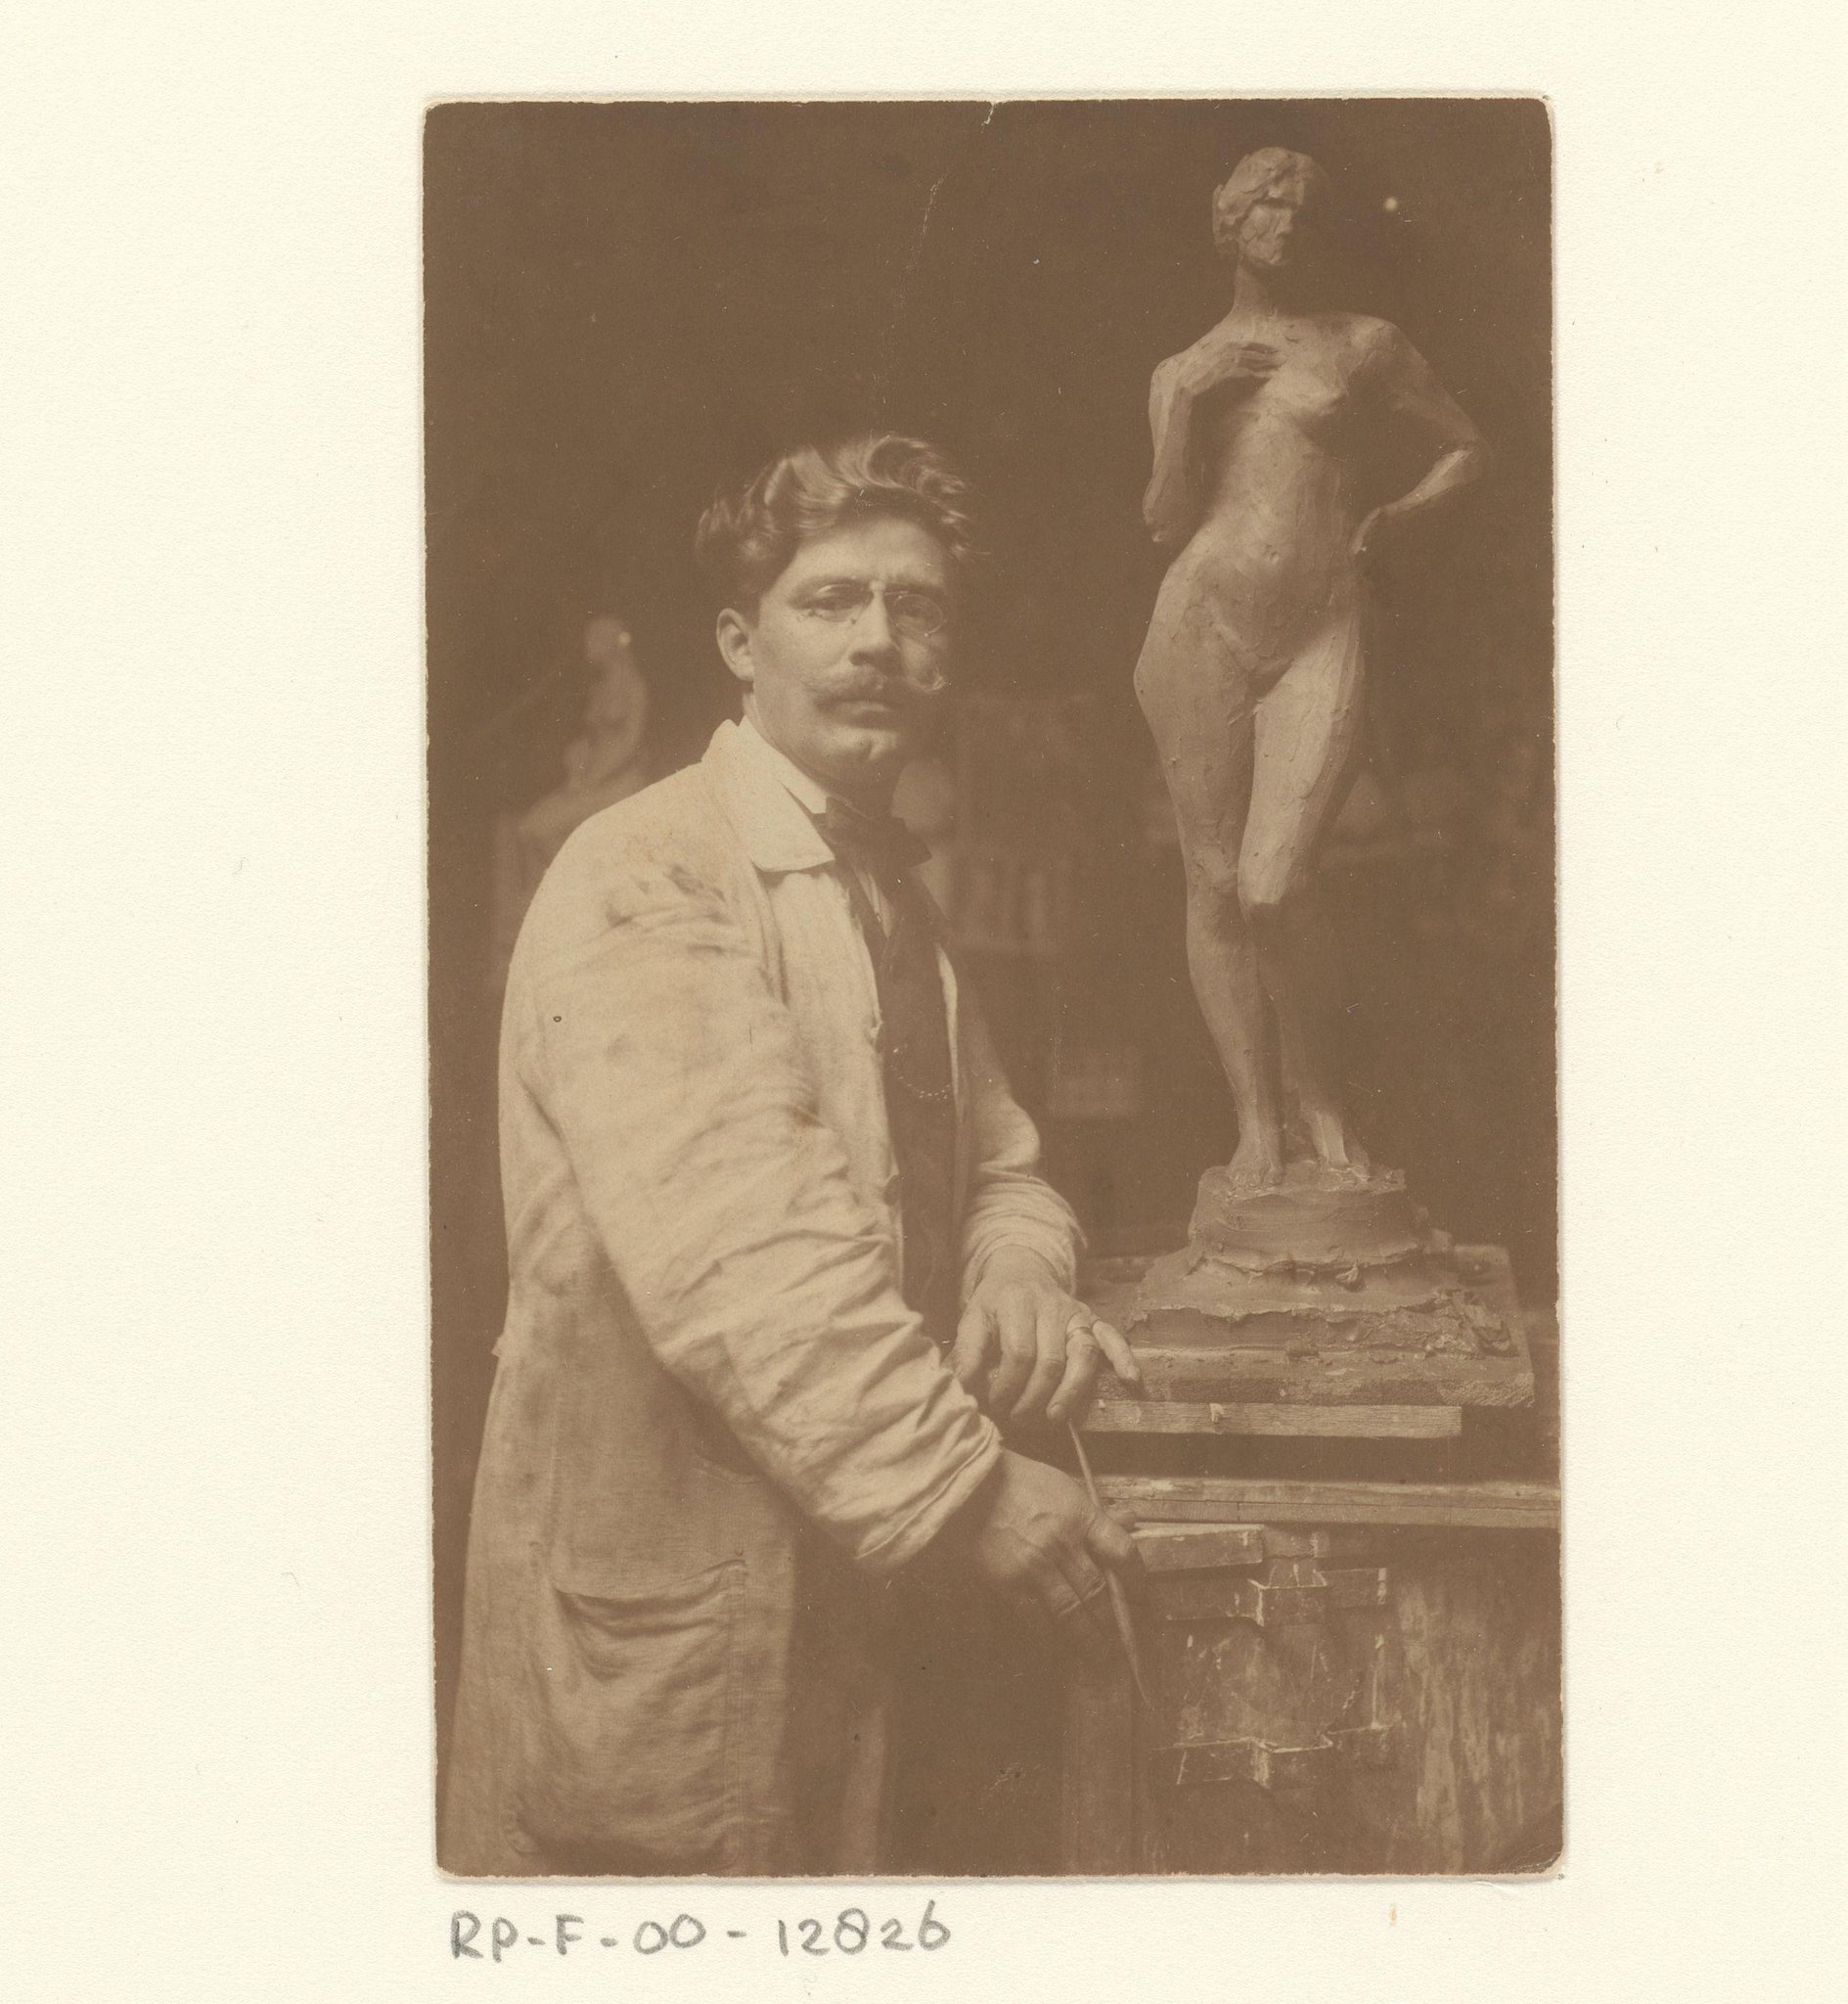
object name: photograph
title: Portret van Toon Depuis in zijn atelier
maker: Anonymous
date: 1910-1920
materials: paper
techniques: gelatin silver print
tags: antwerp, portrait, self-portrait of artist, artist at work, in his workshop